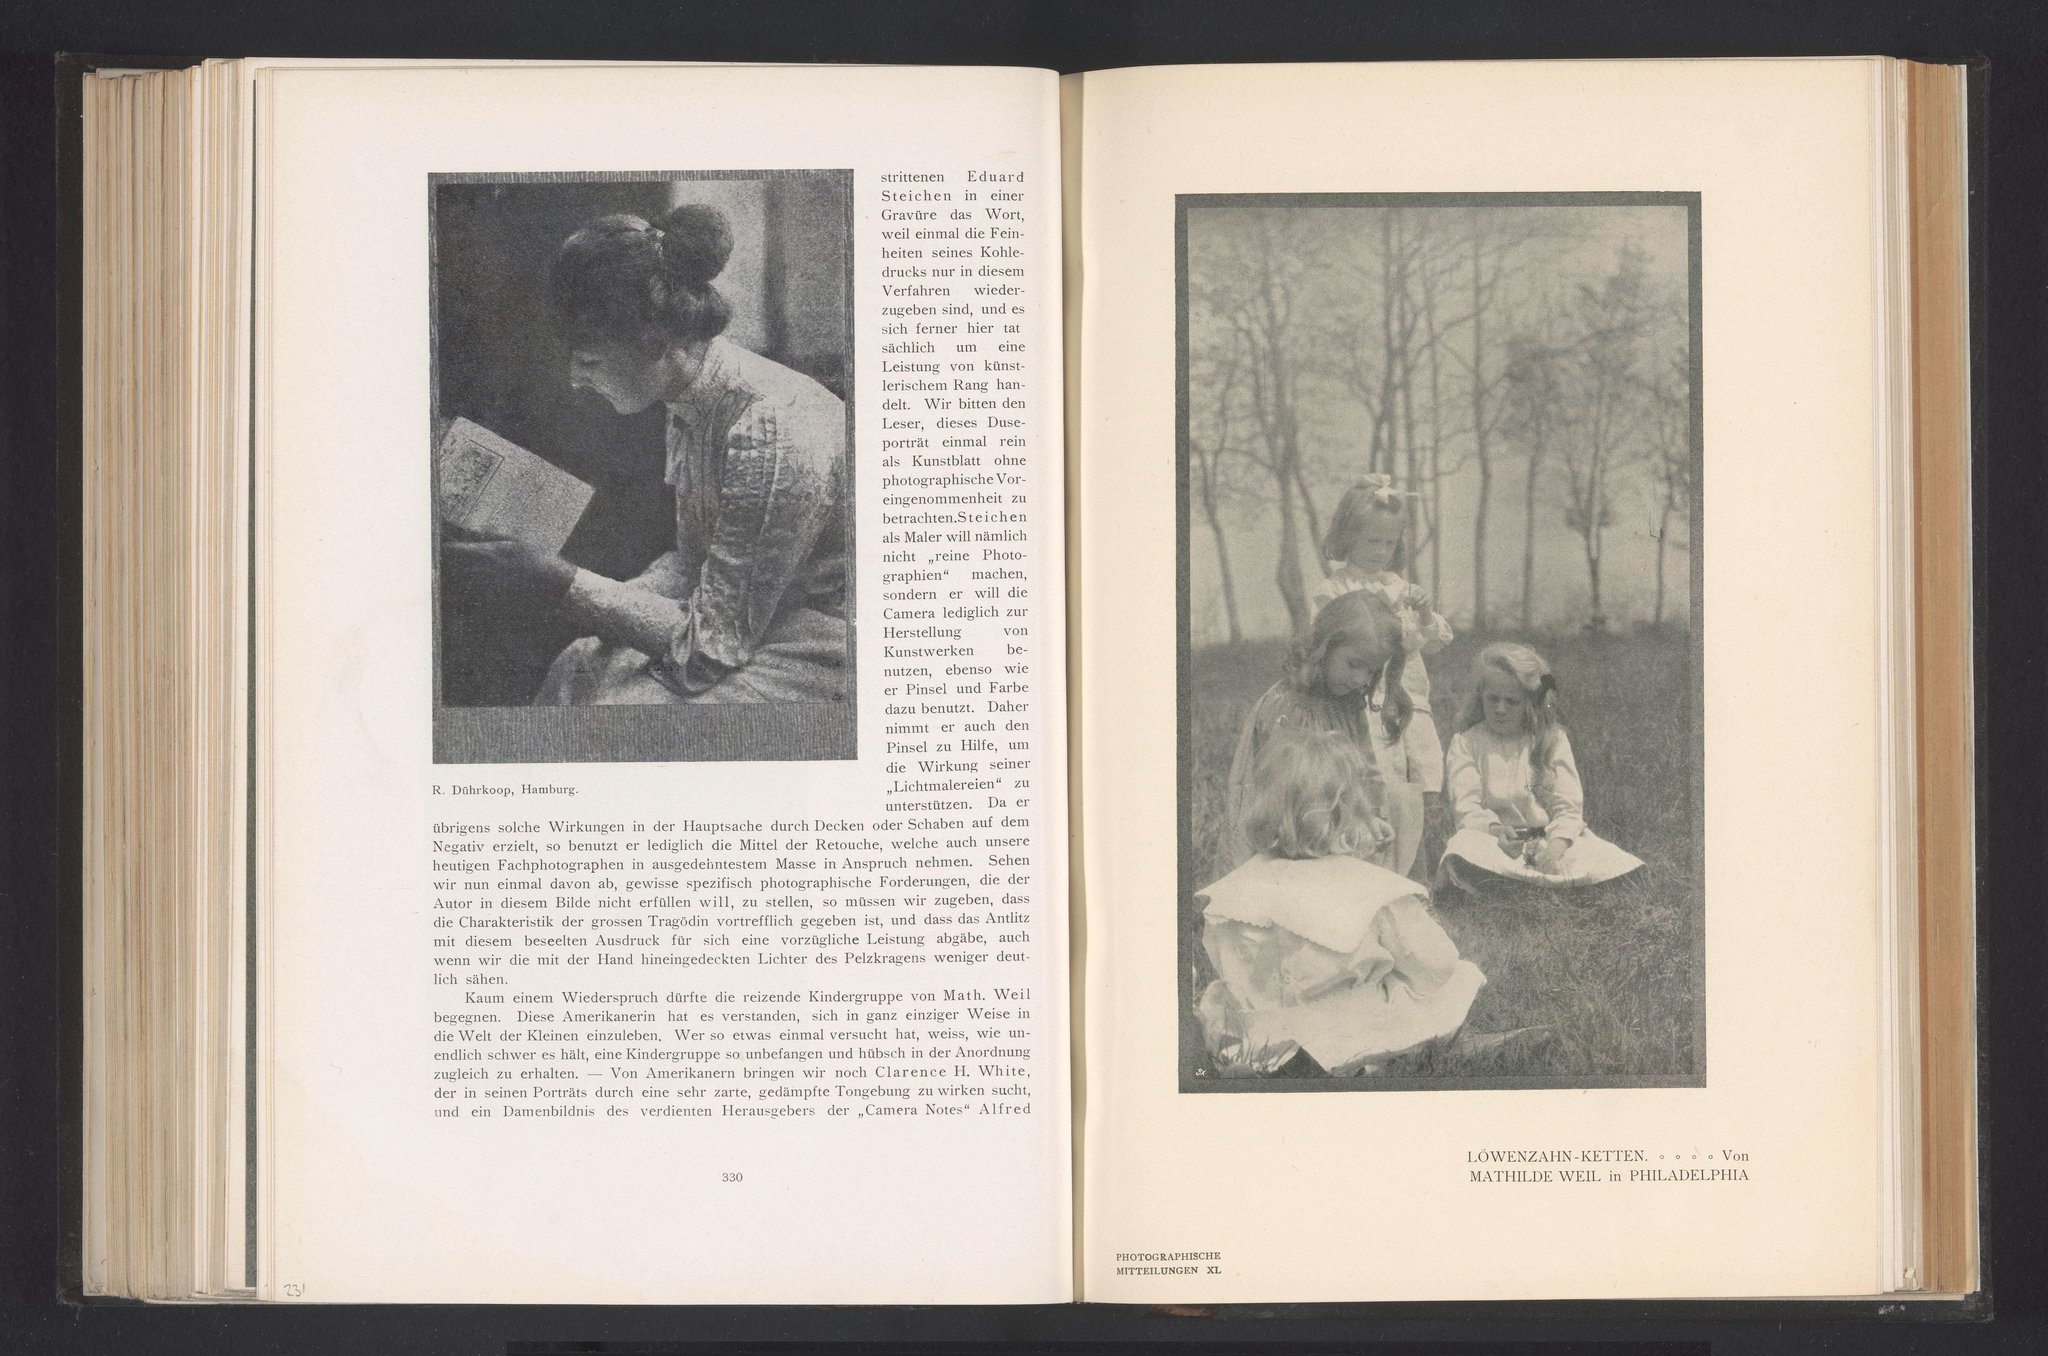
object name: page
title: Portret van een onbekende vrouw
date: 1898-1903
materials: paper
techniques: autotype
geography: hamburg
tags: historical persons - bb - woman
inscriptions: monogram: ‘BX’